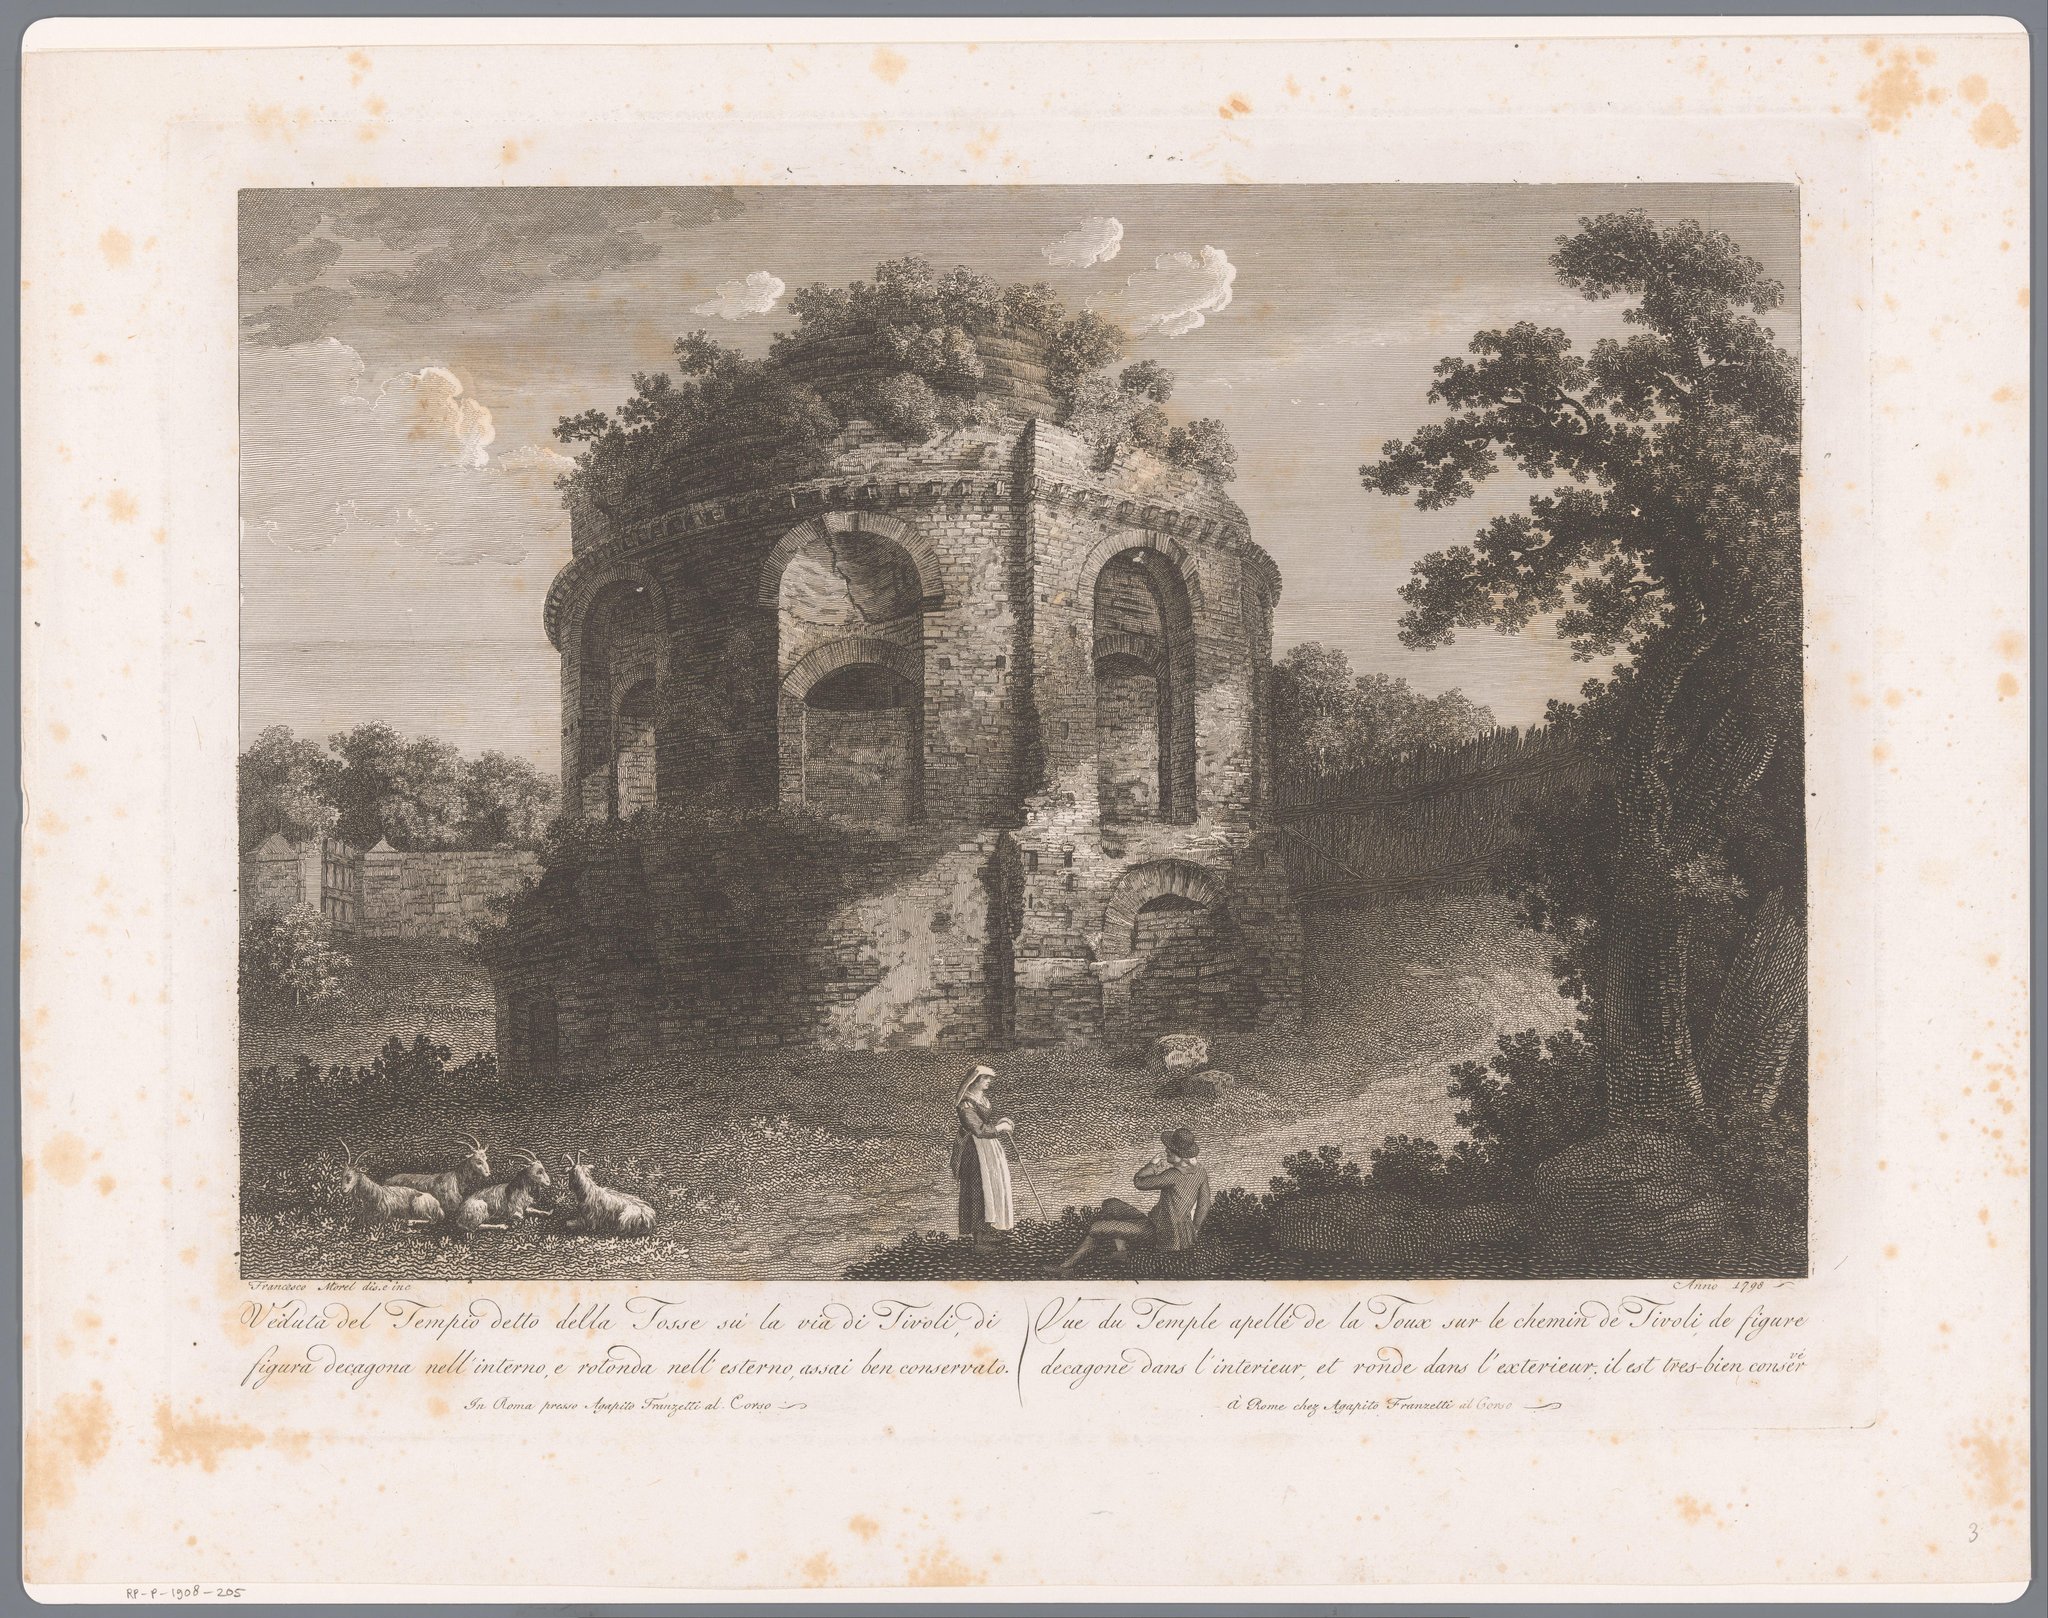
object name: print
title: Gezichten op Rome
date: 1798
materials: paper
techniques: etching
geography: rome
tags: ruin of a building ~ architecture, temple, shrine ~ roman religion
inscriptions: collector's mark: Lugt 2228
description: Maakt deel uit van een serie met gezichten op Rome.